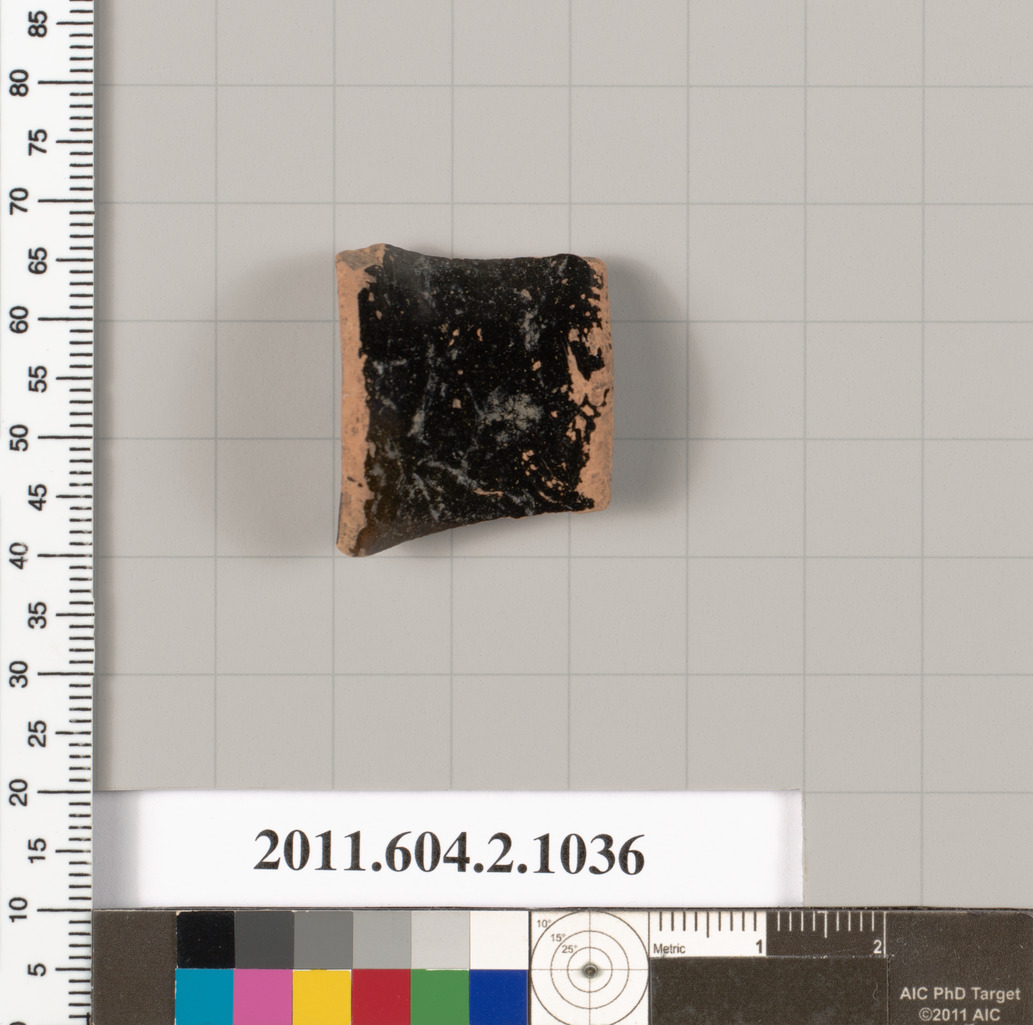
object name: oinochoe fragment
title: Terracotta fragment of an oinochoe (jug)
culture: greek, attic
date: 475-425 BCE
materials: terracotta